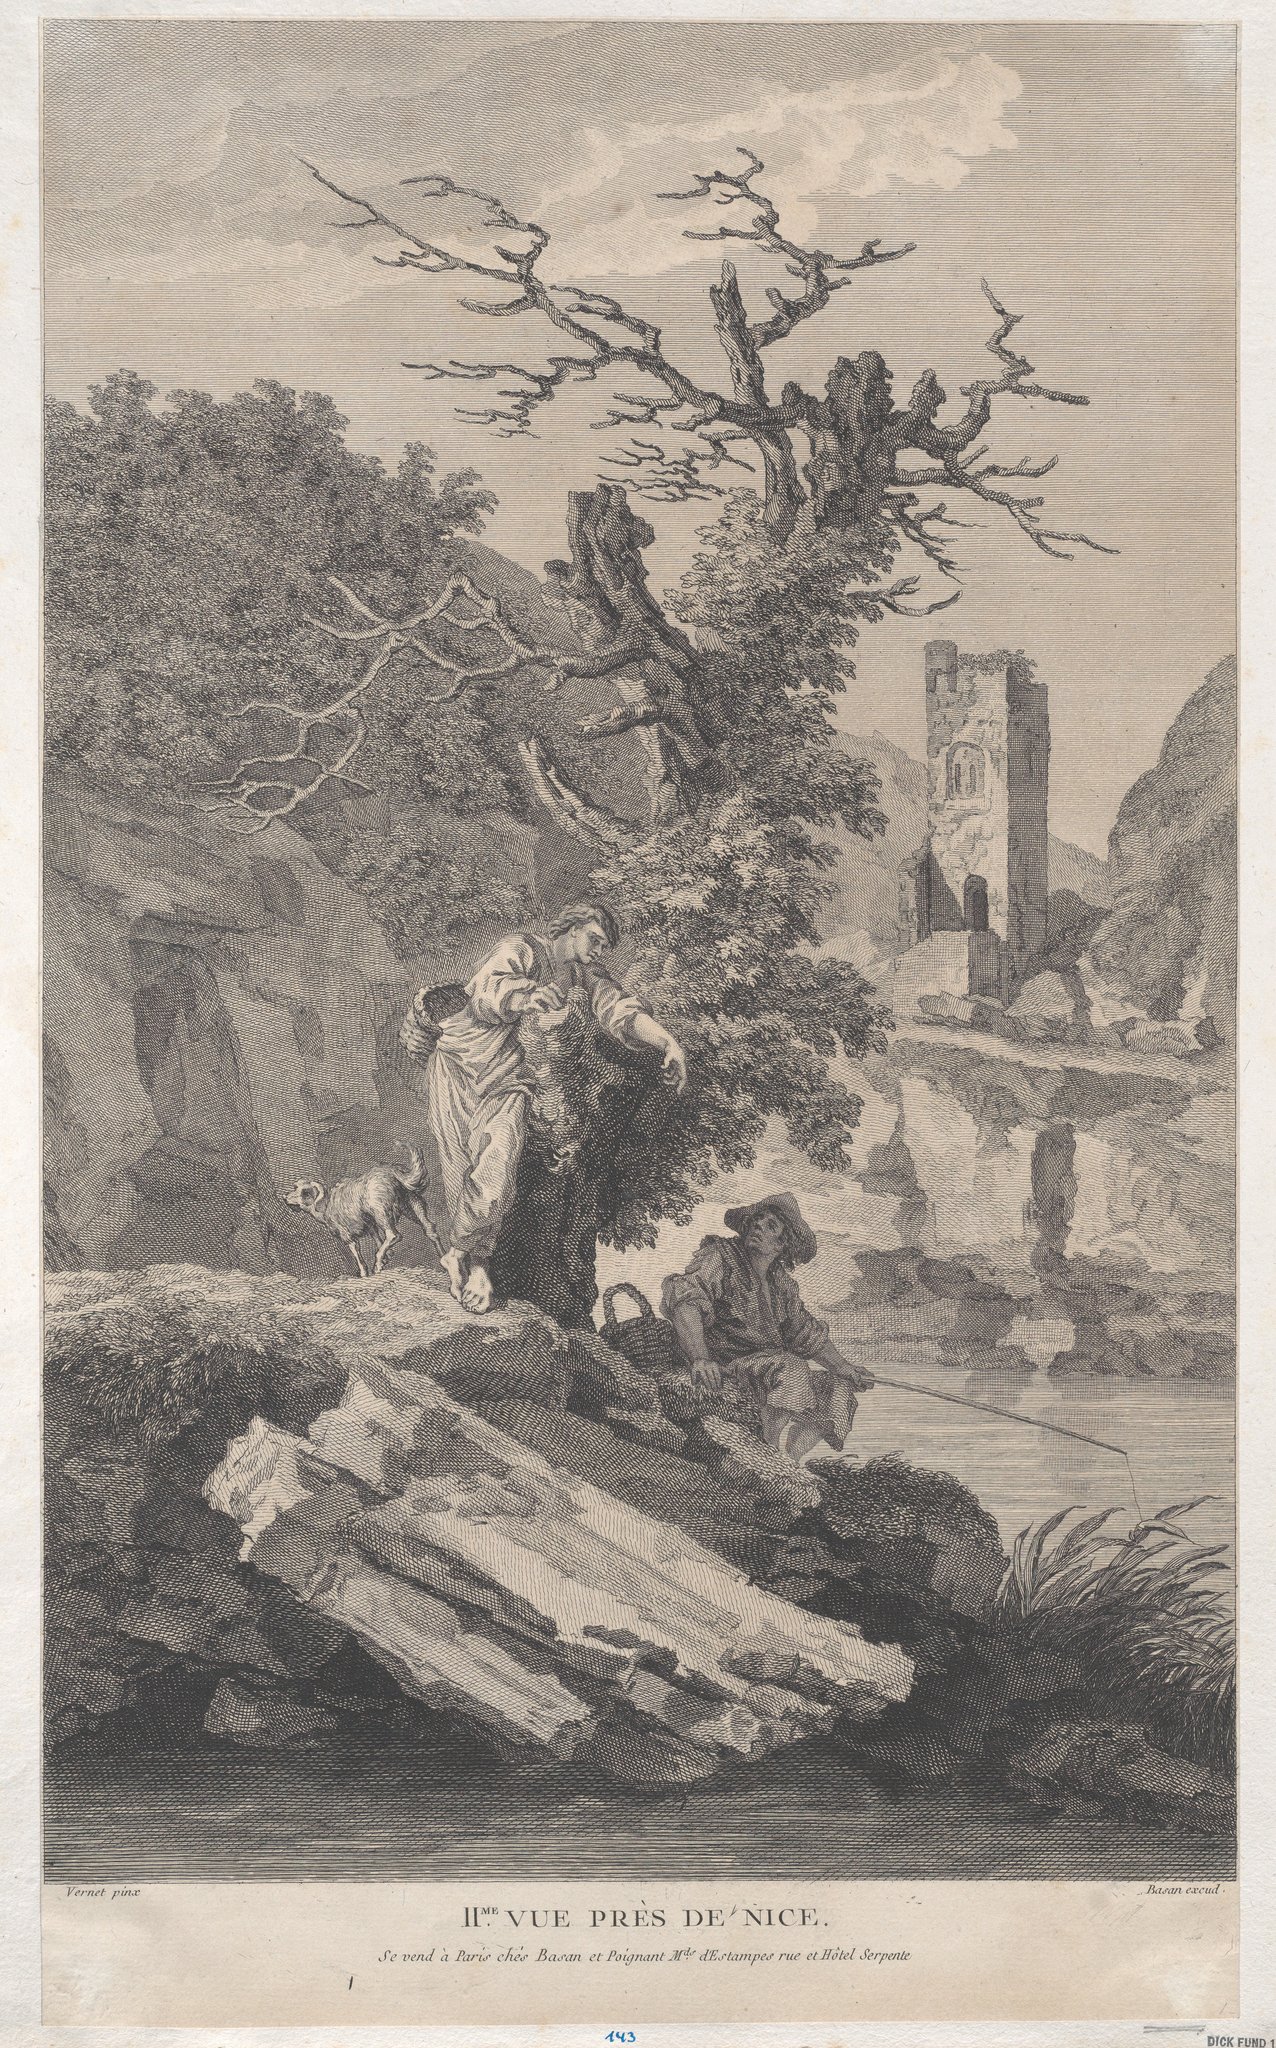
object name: print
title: Second View Close to Nice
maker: joseph vernet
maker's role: artist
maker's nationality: french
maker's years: 1714-1789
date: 1750-1800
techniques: engraving